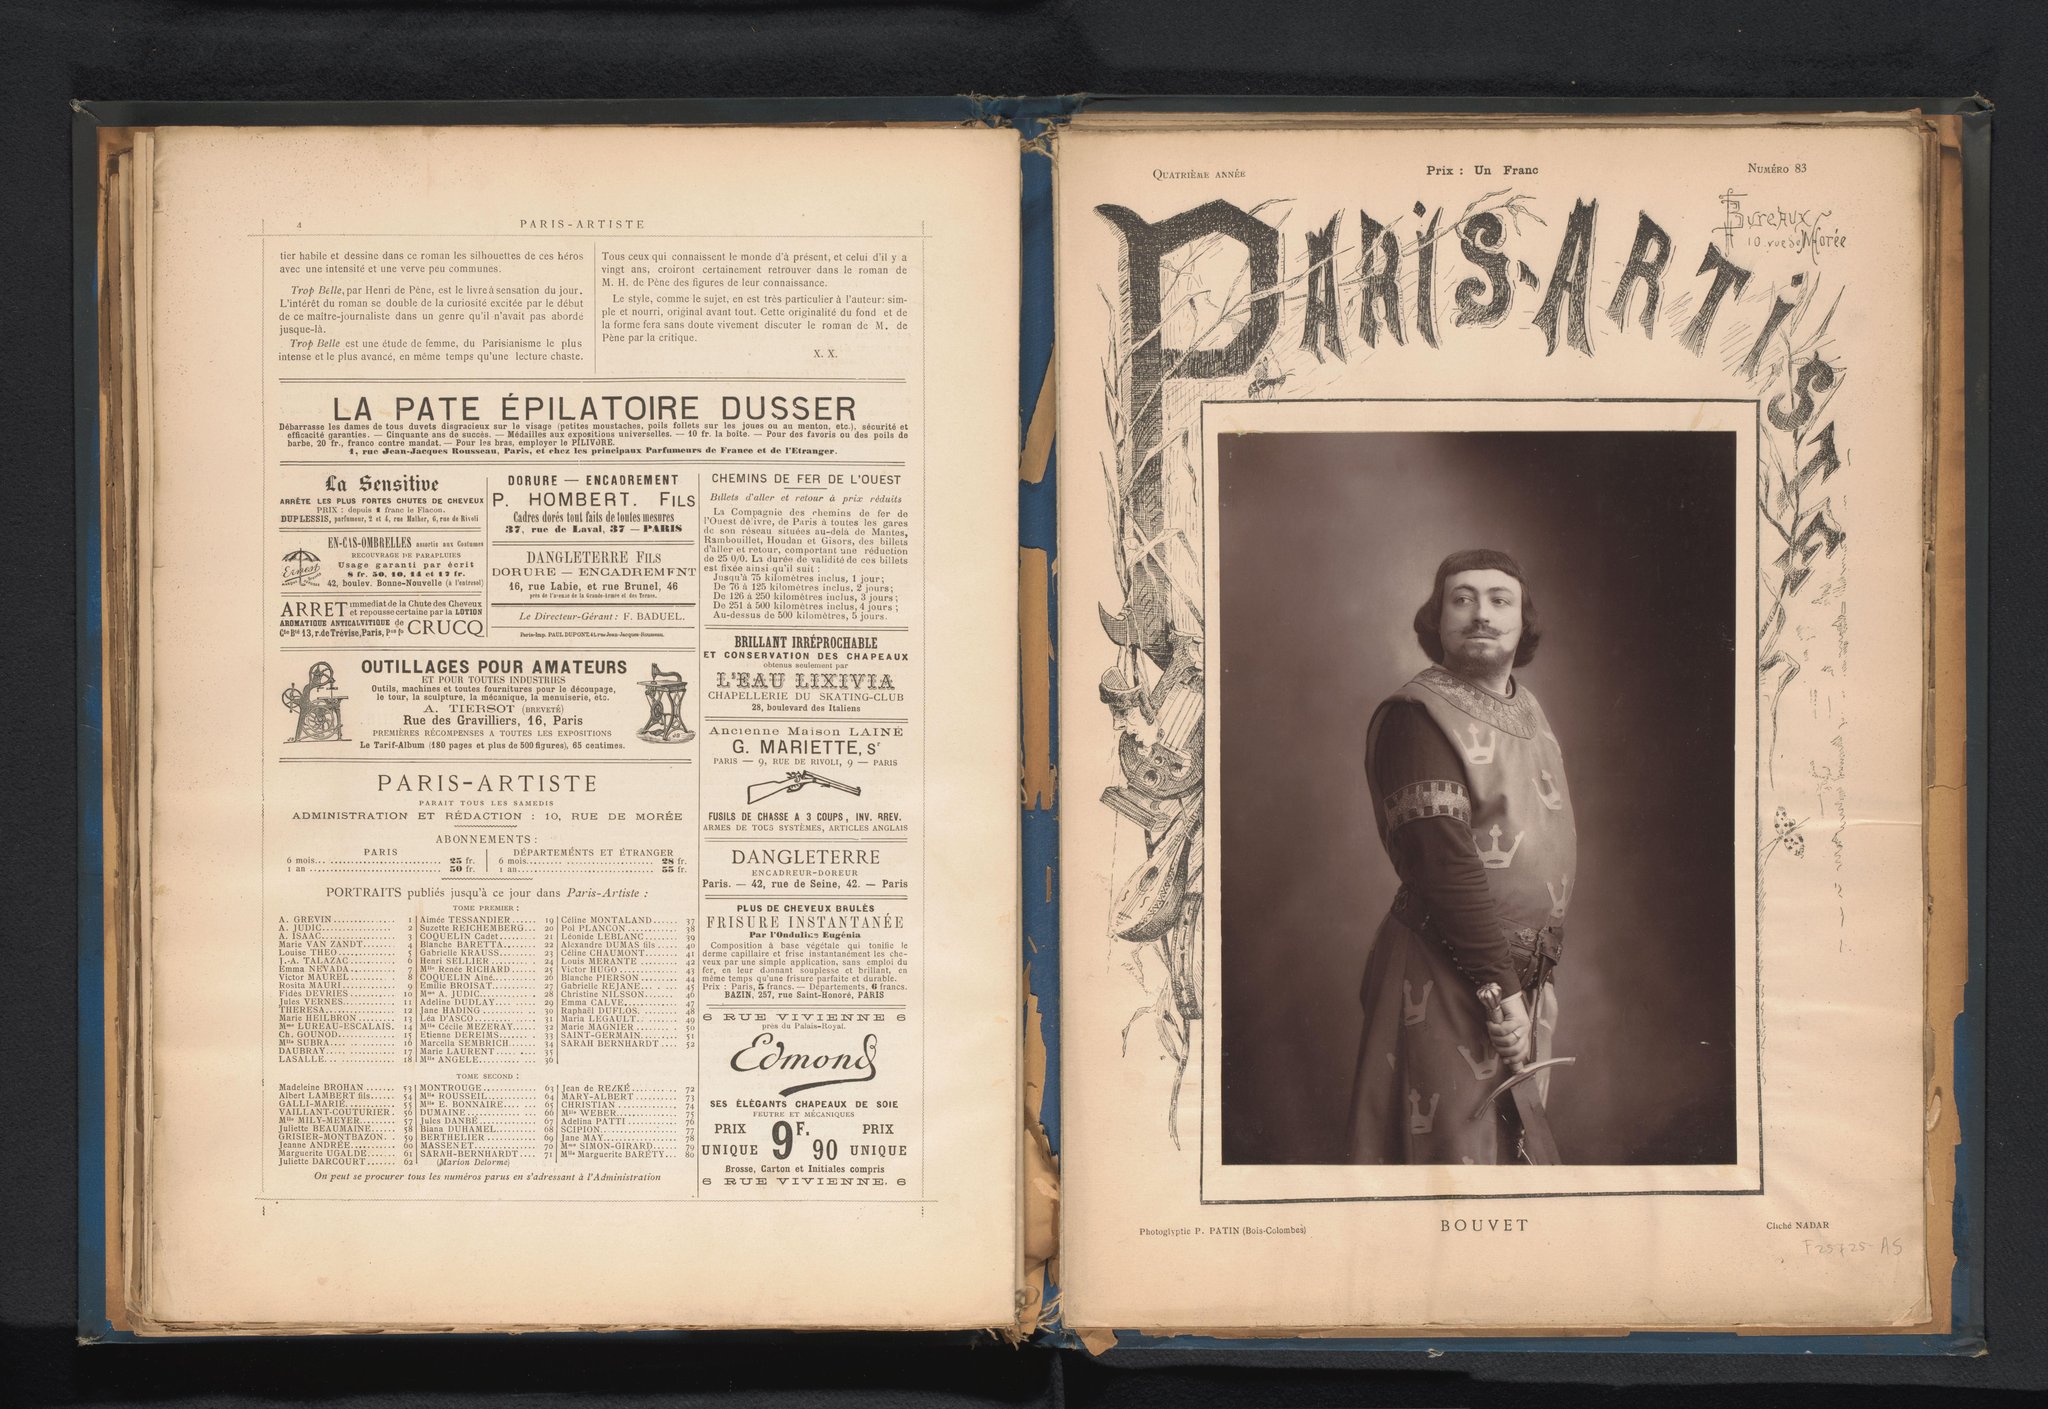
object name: page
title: Portret van een onbekende man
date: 1880-1886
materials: paper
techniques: woodburytype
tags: historical persons, portrait of actor, actress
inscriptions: name: ‘Bouvet’